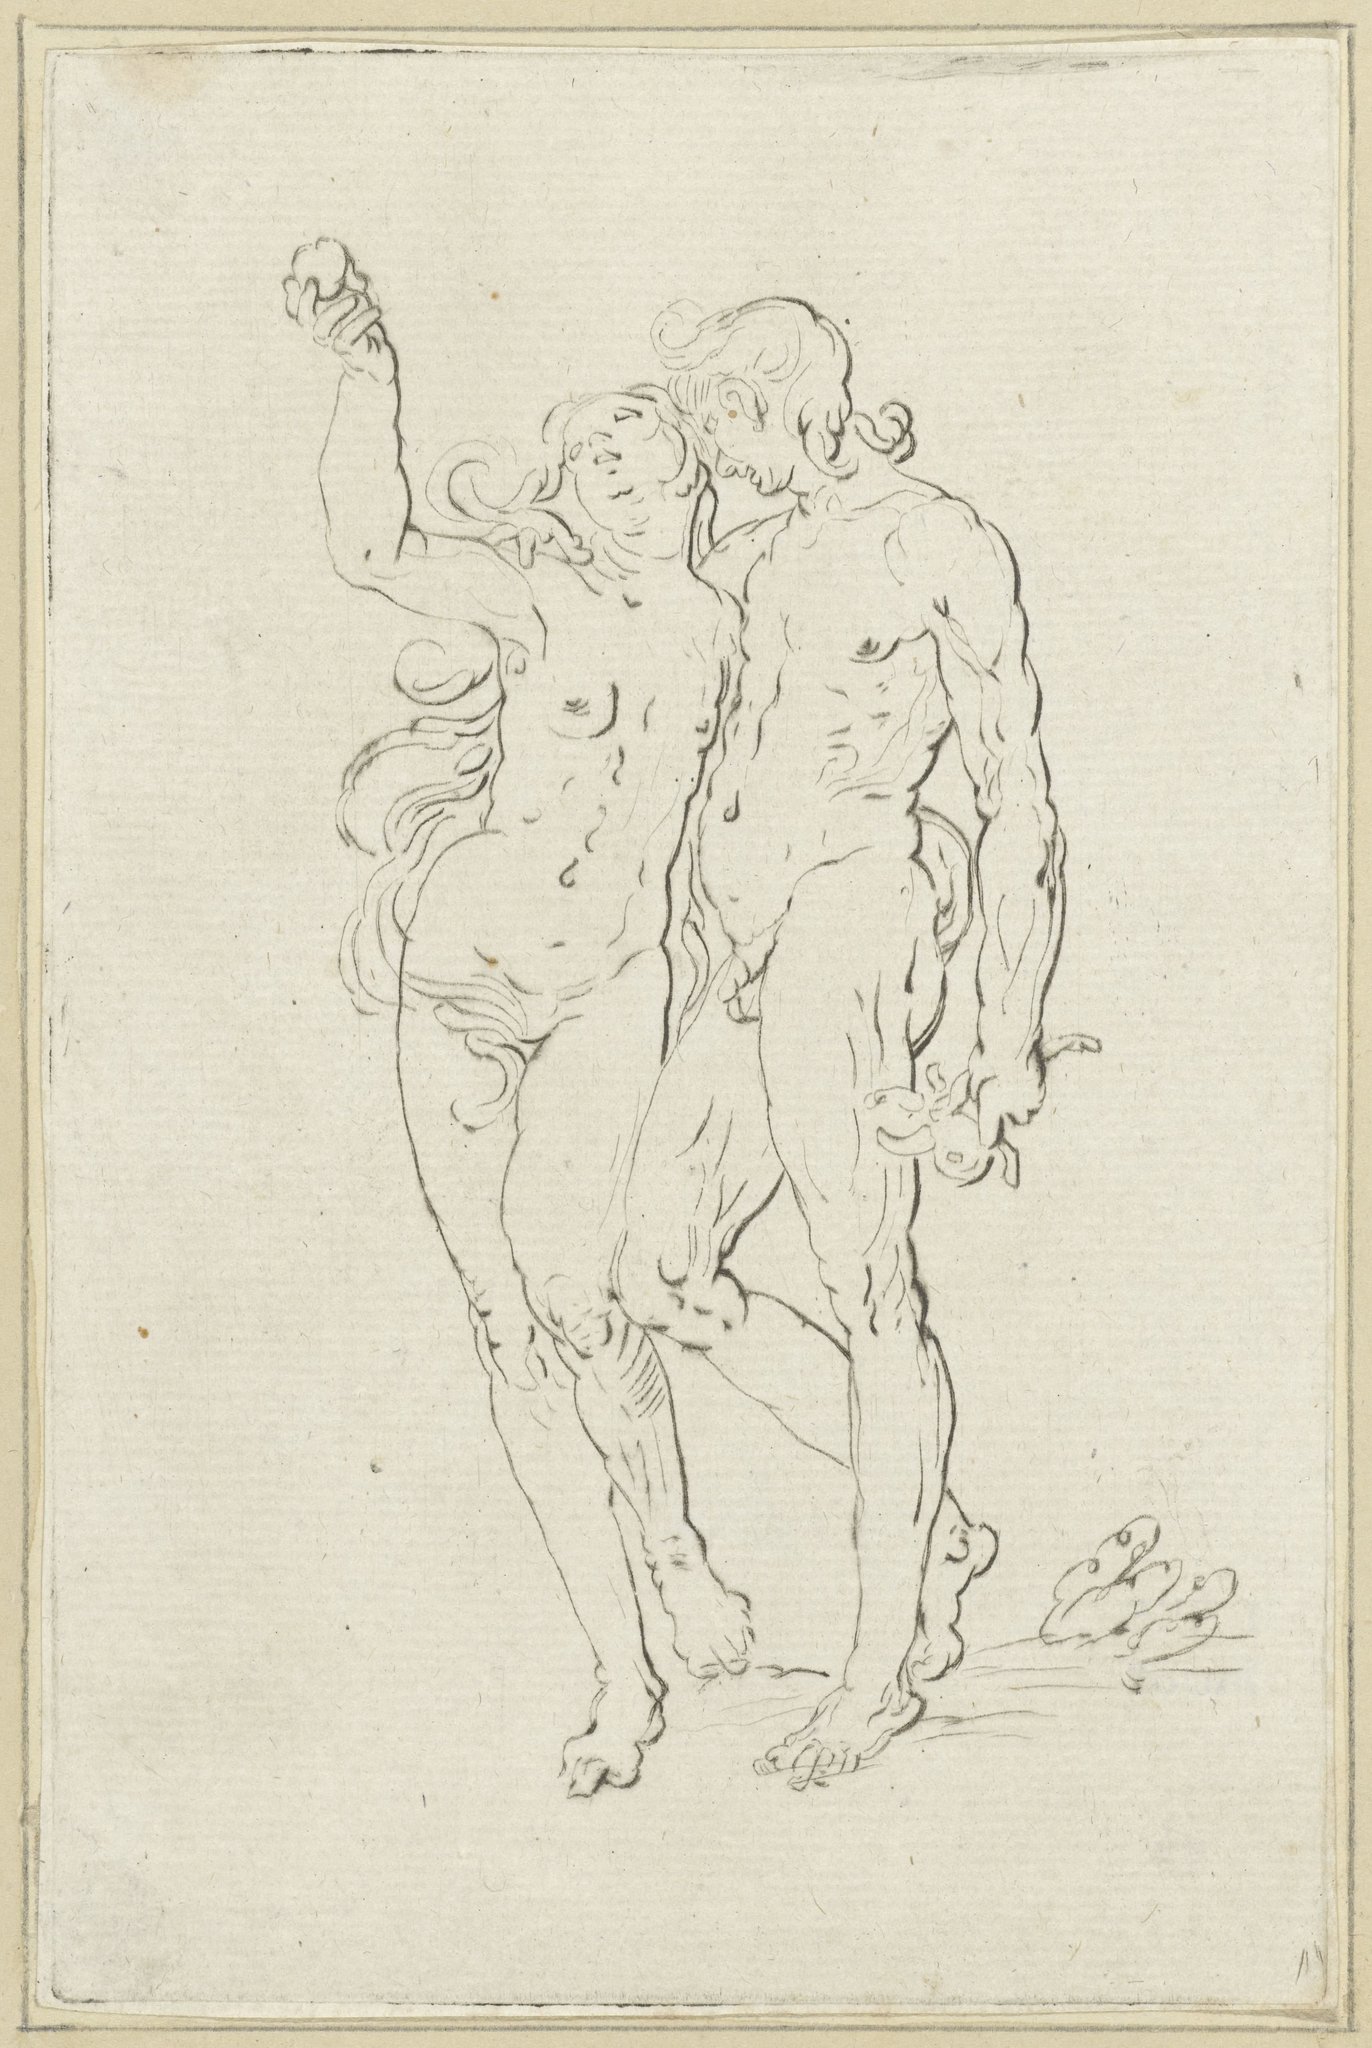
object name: print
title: Adam en Eva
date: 1736-1848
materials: paper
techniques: printmaking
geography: netherlands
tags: adam and eve holding (and possibly eating) the fruit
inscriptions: collector's mark: Lugt 2166, collector's mark: Lugt 2760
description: De naakte Adam en Eva lopen naast elkaar. Eva houdt de appel in haar hand en kijkt ernaar.